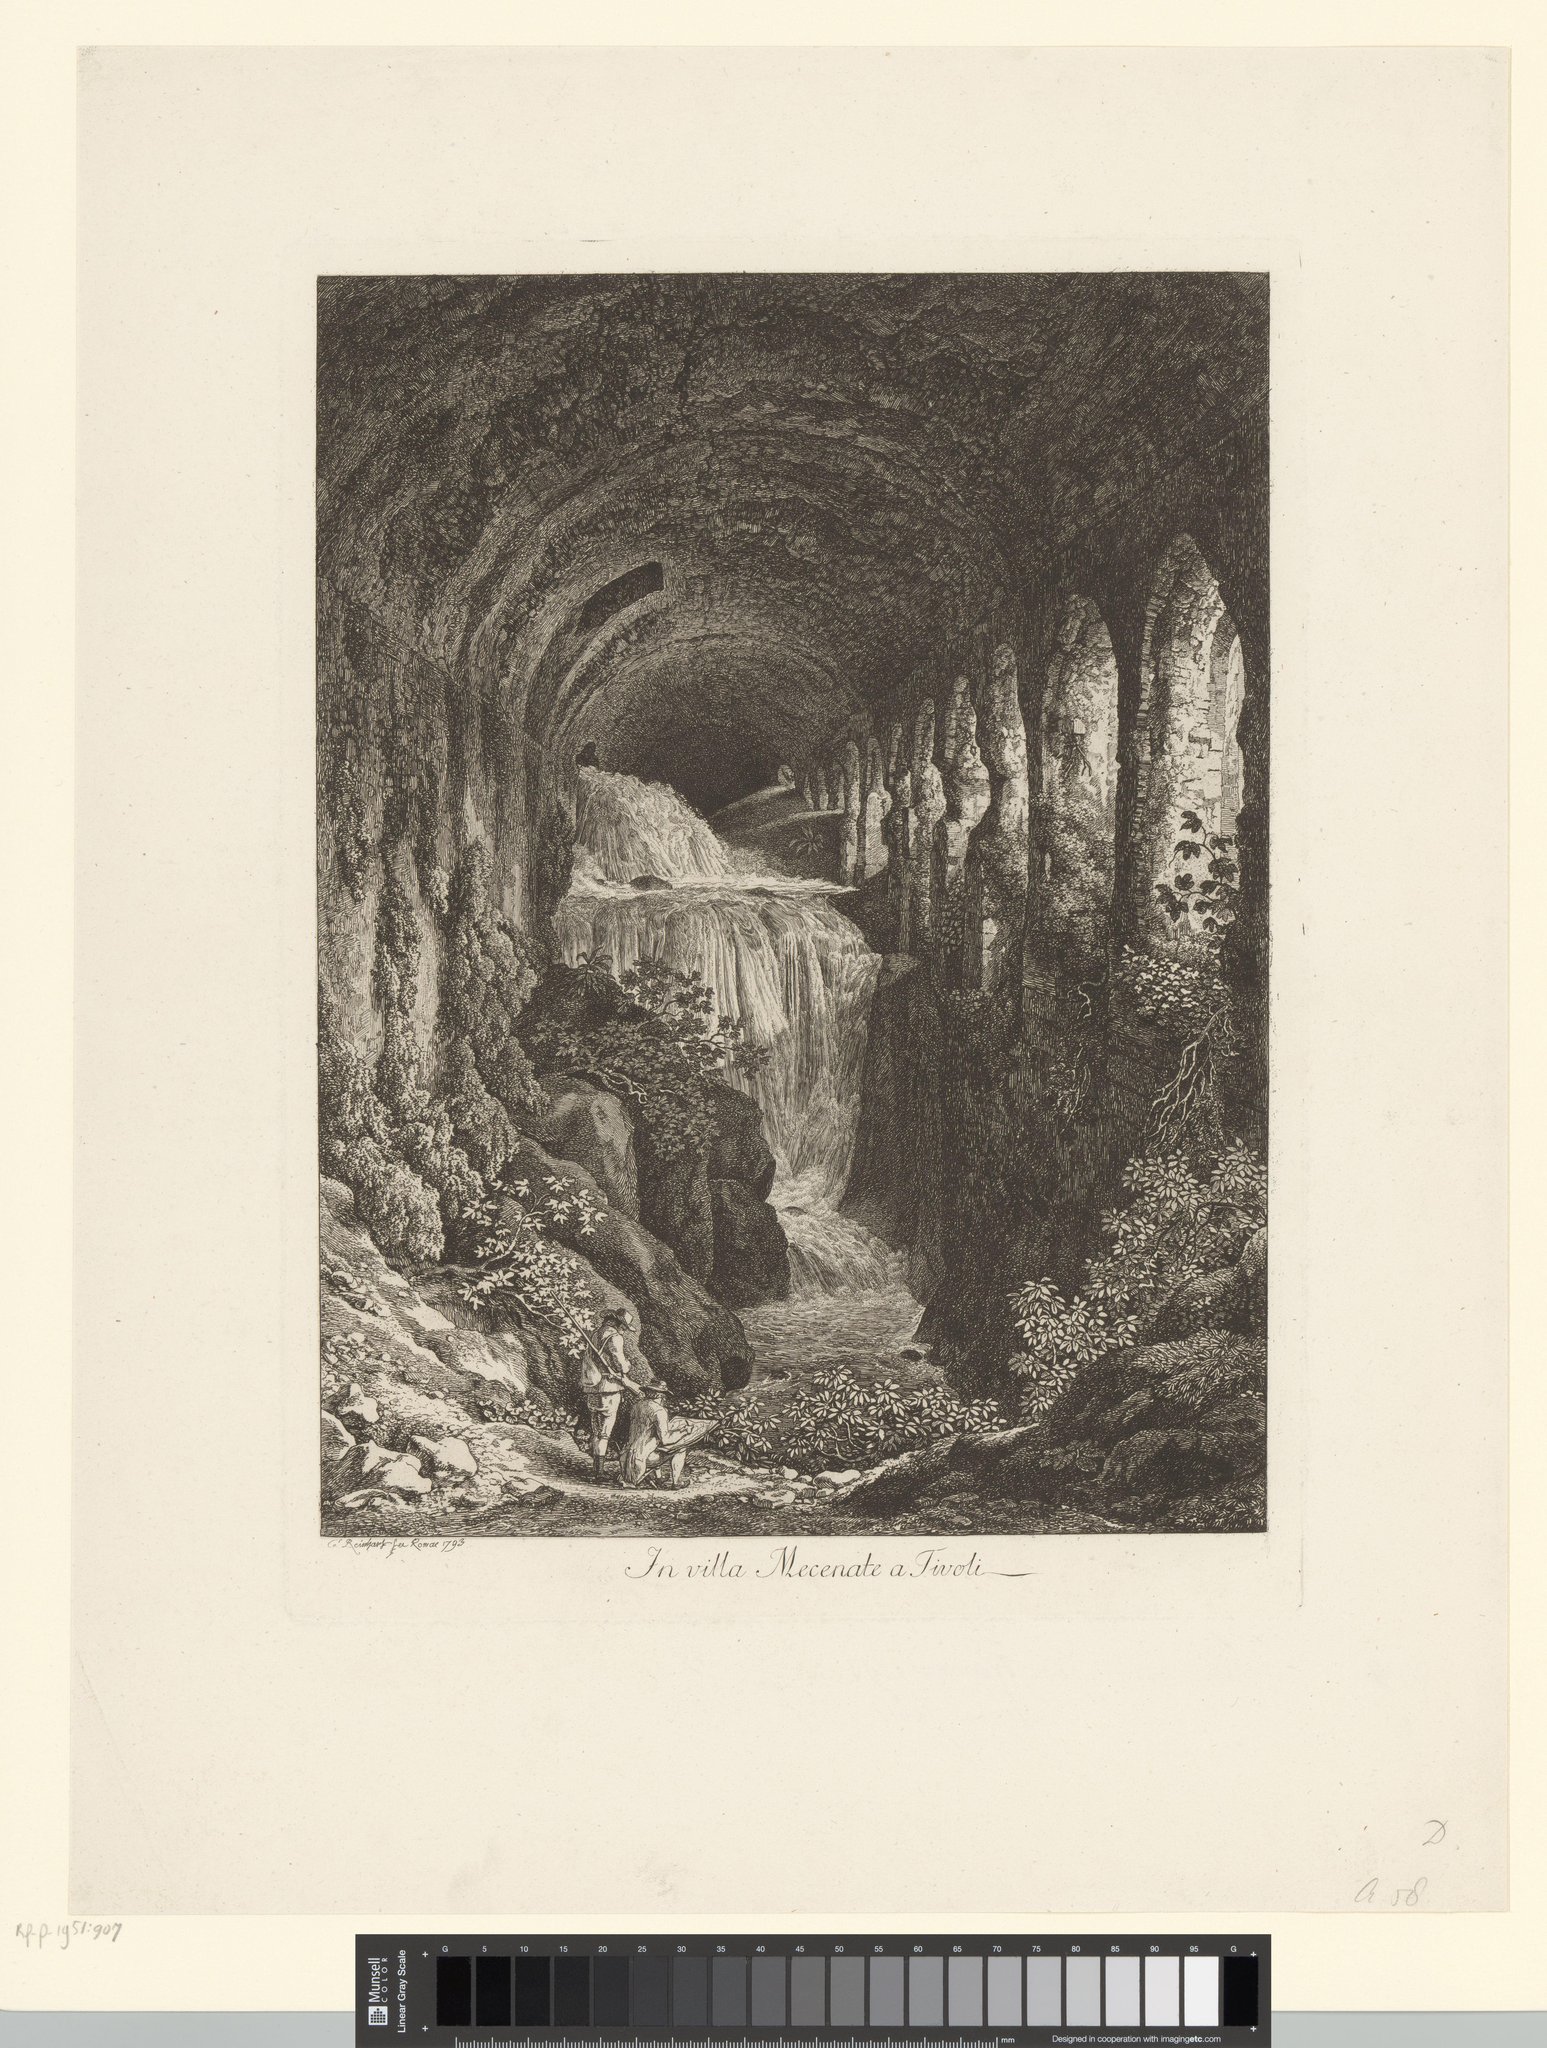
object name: print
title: Interieur van de Villa Mecenate ruïne in Tivoli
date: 1793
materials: paper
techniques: engraving, etching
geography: nuremberg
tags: landscapes, landscape with ruins, monument, statue, draughtsman studying classical remains - cc - out of doors, tivoli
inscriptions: collector's mark: Lugt 2228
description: Behorend tot een serie van 72 'Mahlerisch-radirte Prospecte von Italien', waarvoor de kunstenaar 24 prenten maakte. Albert Christoph Dies (1755-1822) en Jacob Wilhelm Mechau (1745-1808) maakten eveneens 24 platen, in opdracht van Jean Fréderic Frauenholz. Vanaf 1792 verschenen telkens drie sets van twee prenten per kunstenaar. In 1798 werd de laatste set uitgegeven, waarna complete sets gebonden werden uitgegeven tot in 1875 (Nuerenberg: J.L. Lotzbeck). Zie: Schmid, F.C., A.C. Dies, J.W. Mechau und J.C. Reinhart 'Mahlerische radirte Prospecte von Italien' (...). Berlijn: s.n., 1991.